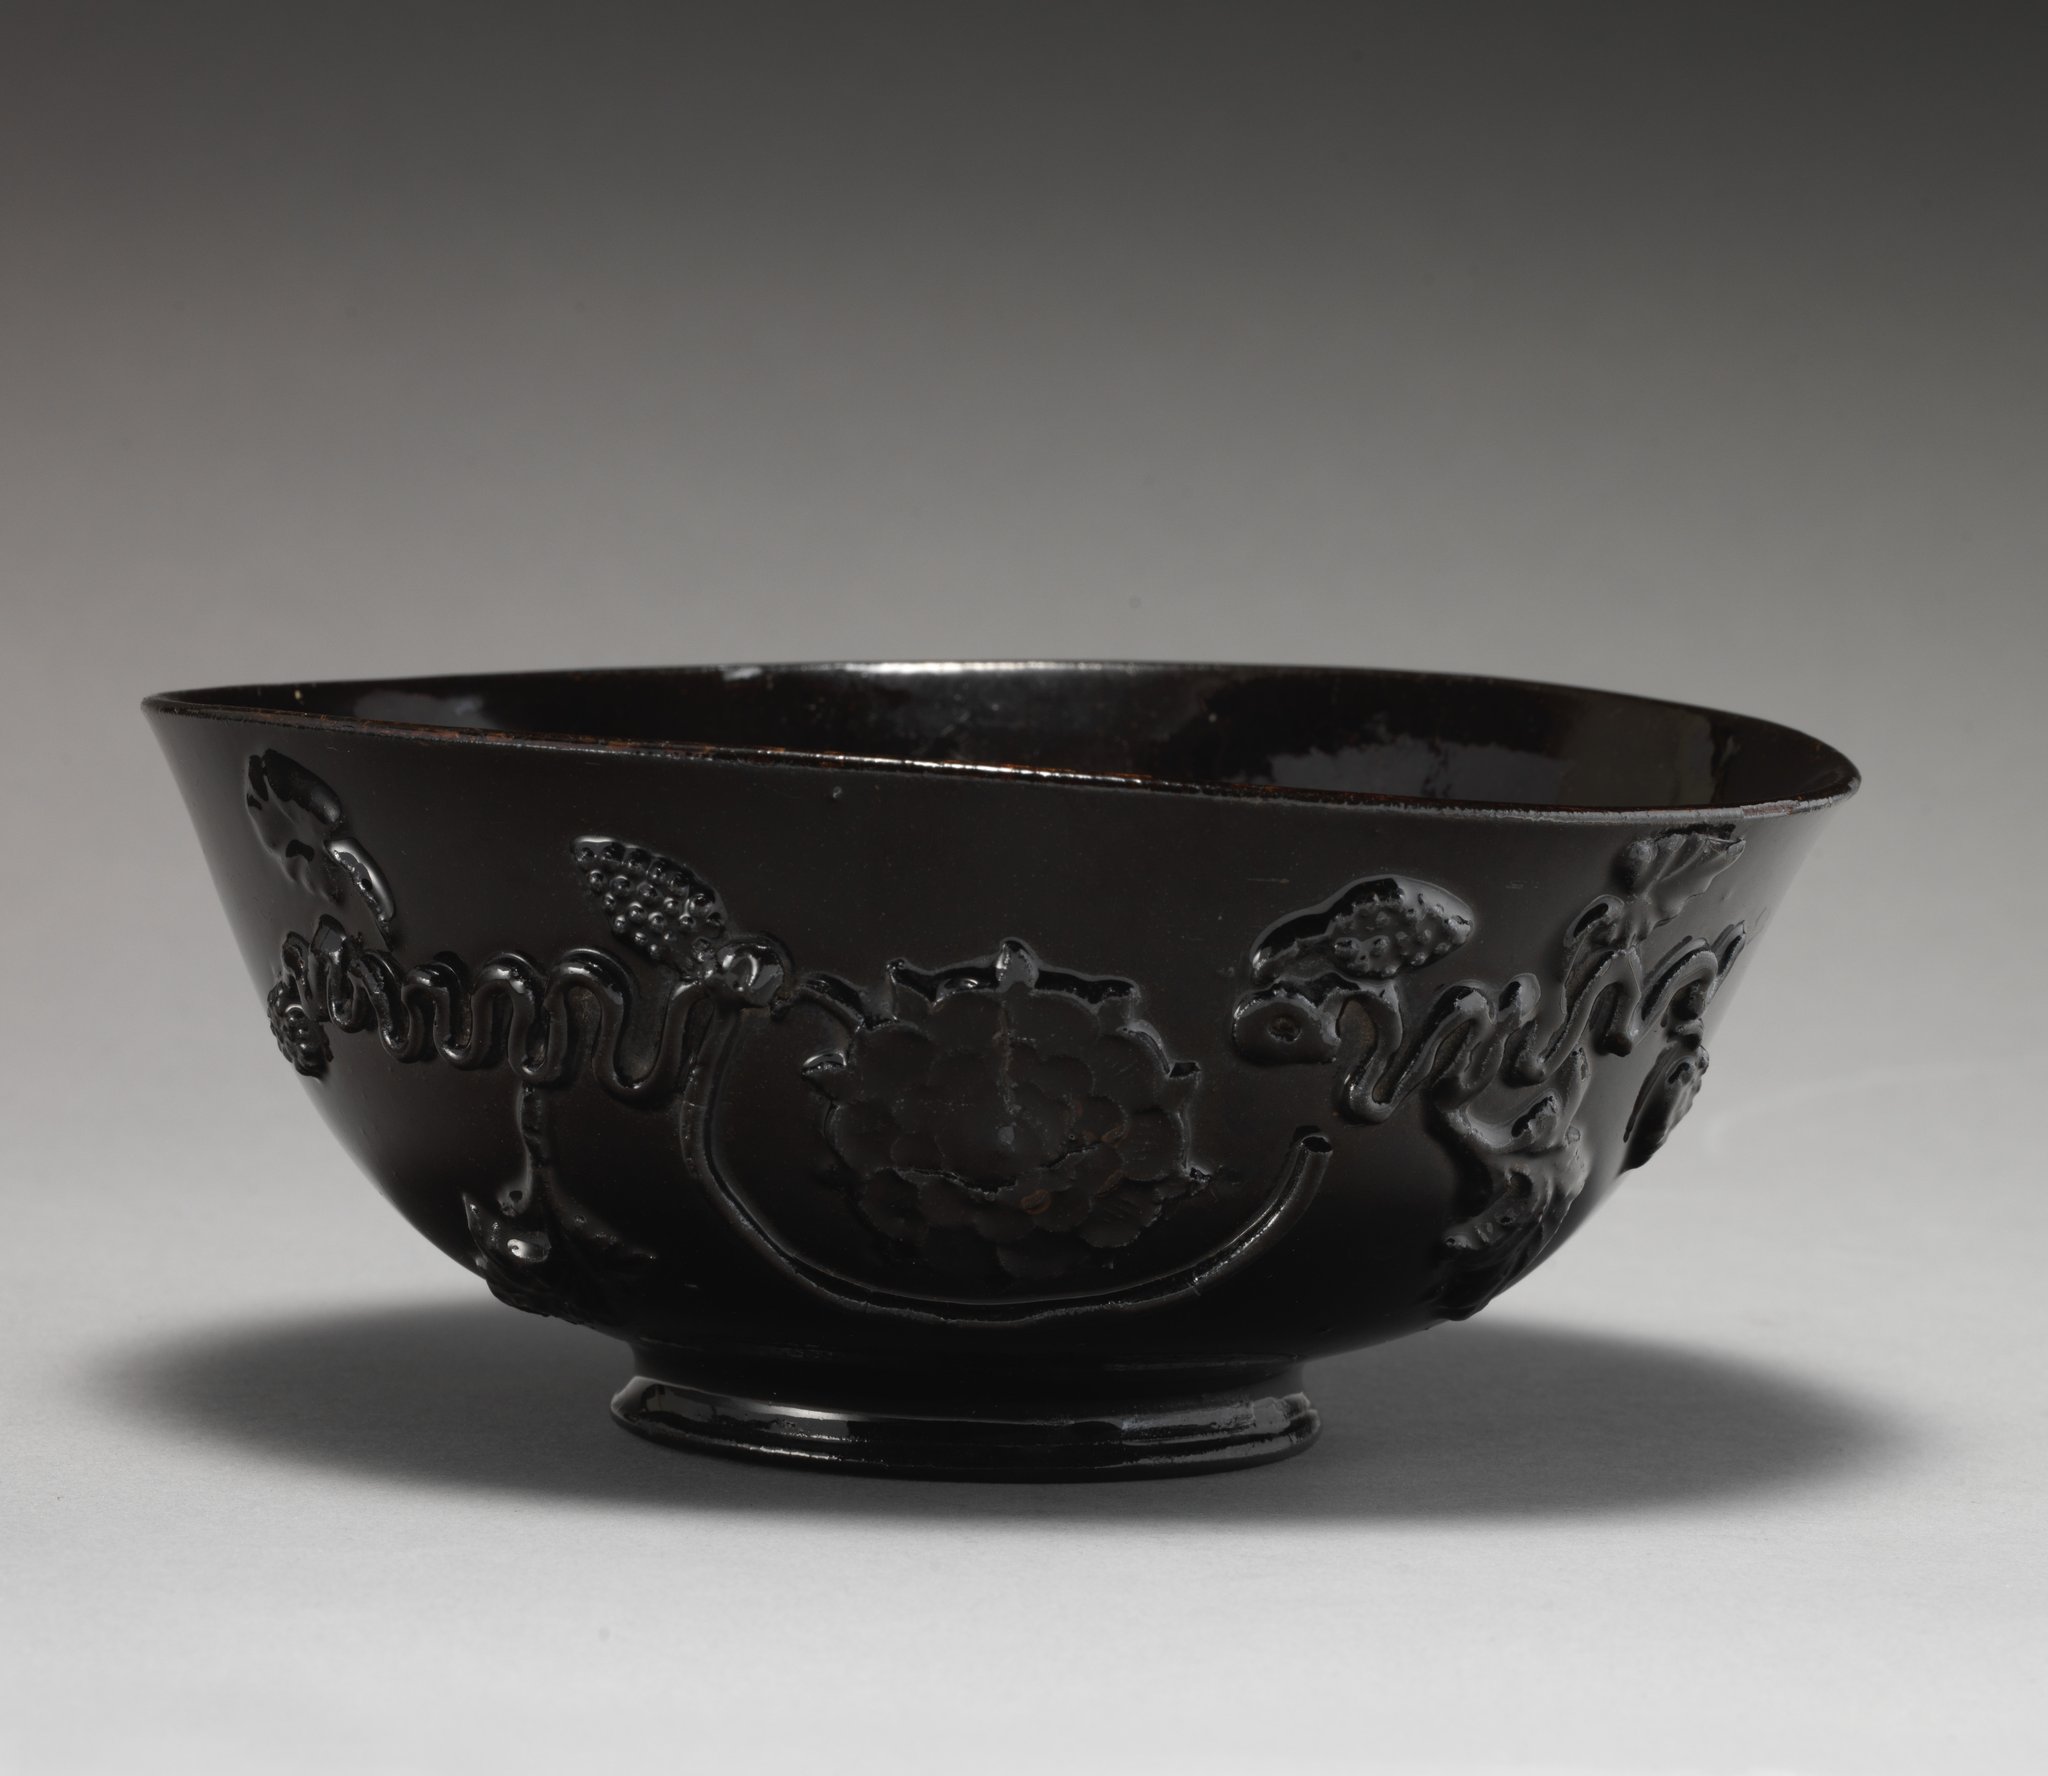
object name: bowl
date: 1755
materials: earthenware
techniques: glazing